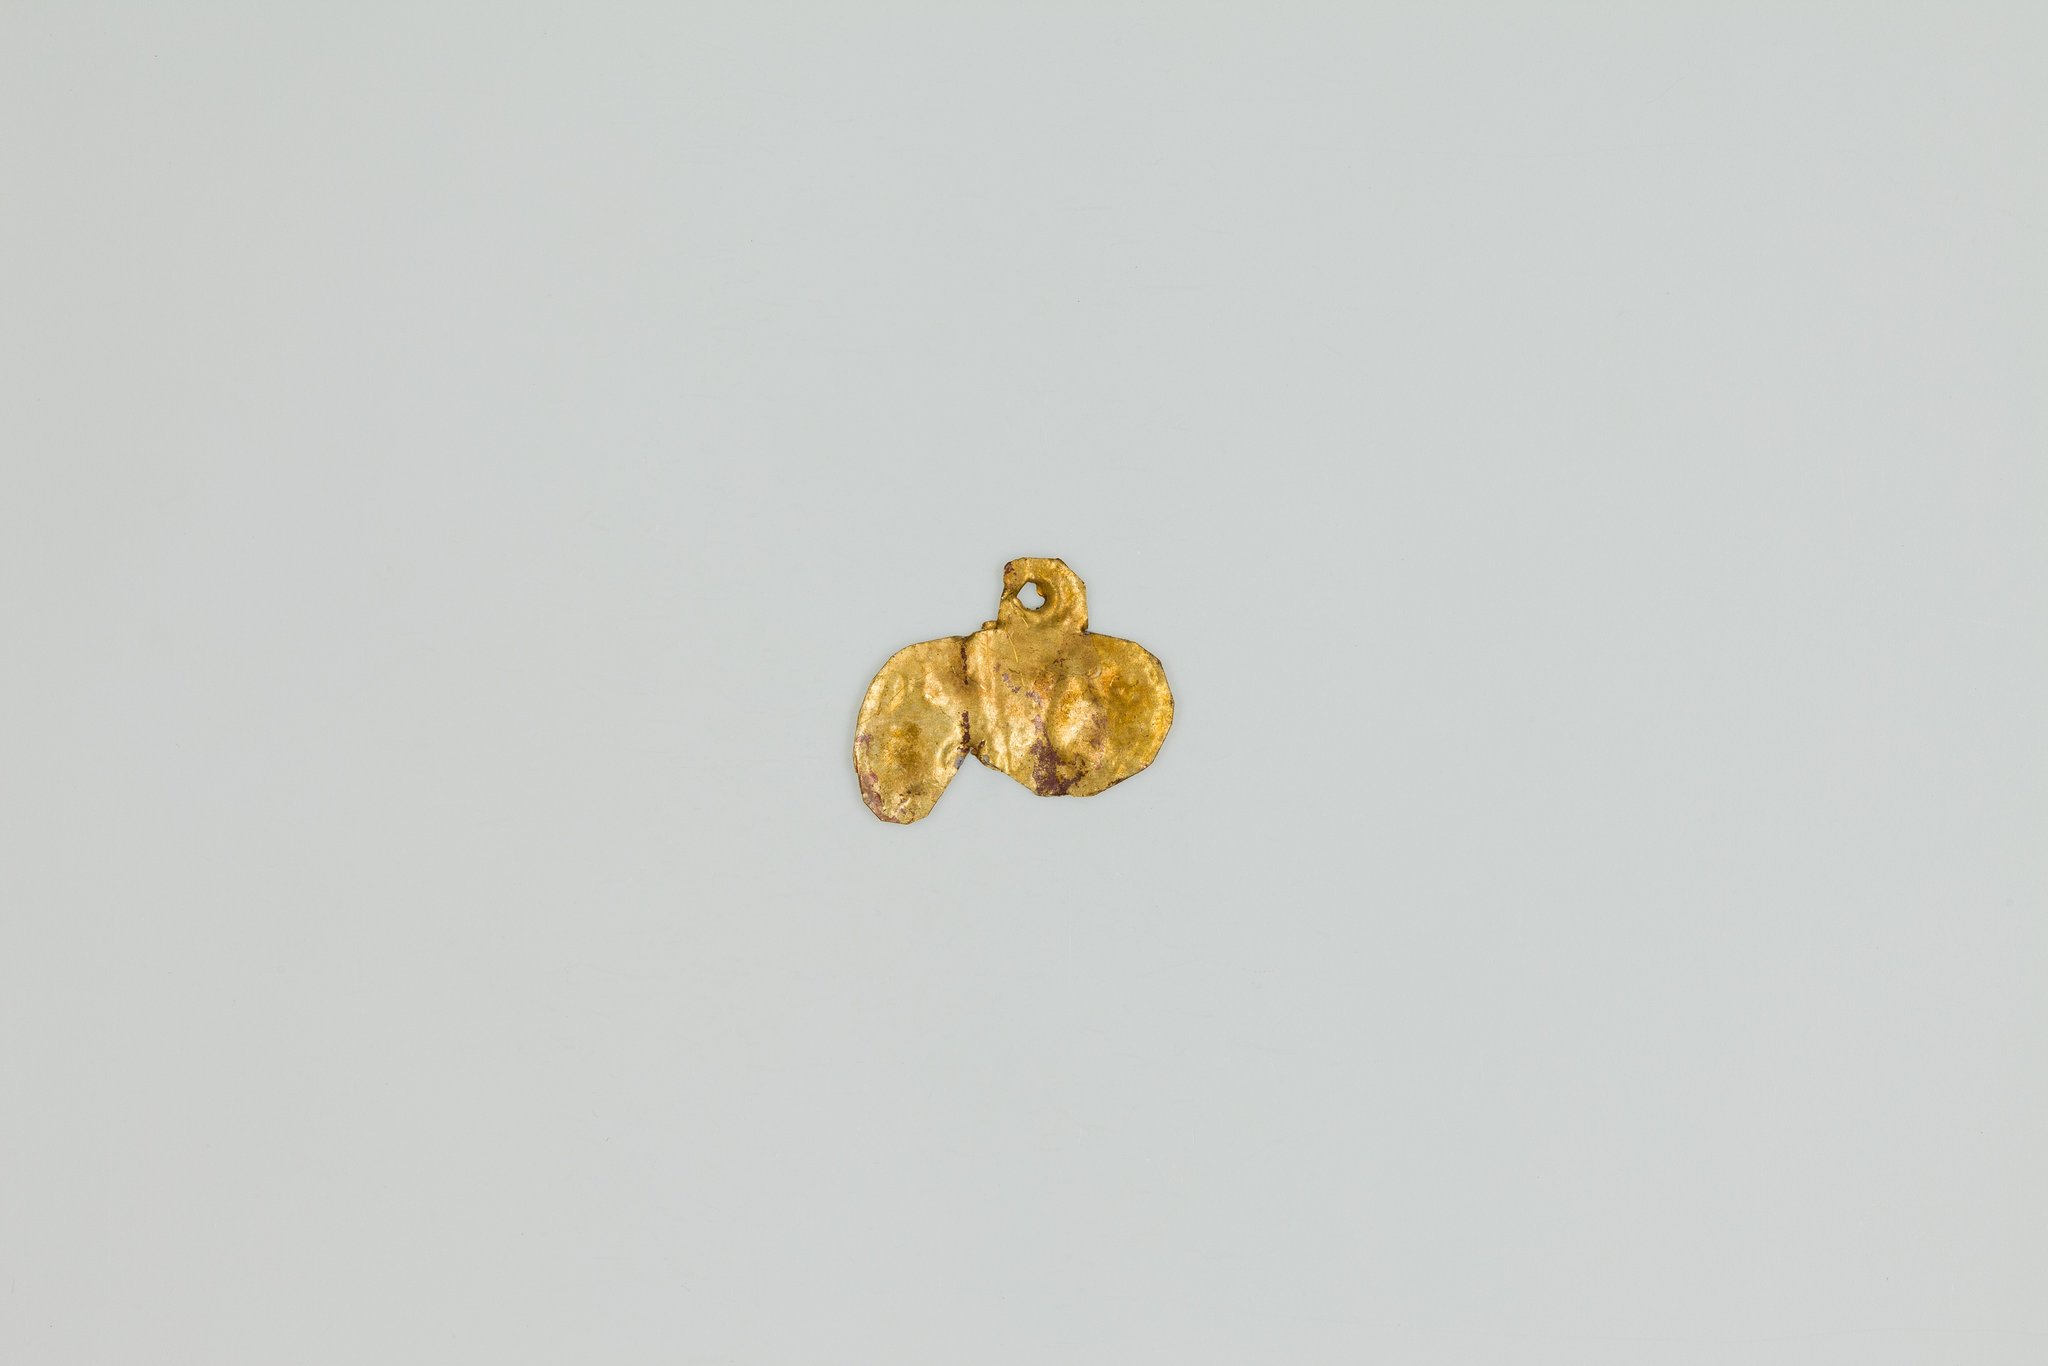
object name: amulet, phallus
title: Phallus (?) amulet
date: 664-380 BCE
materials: gold